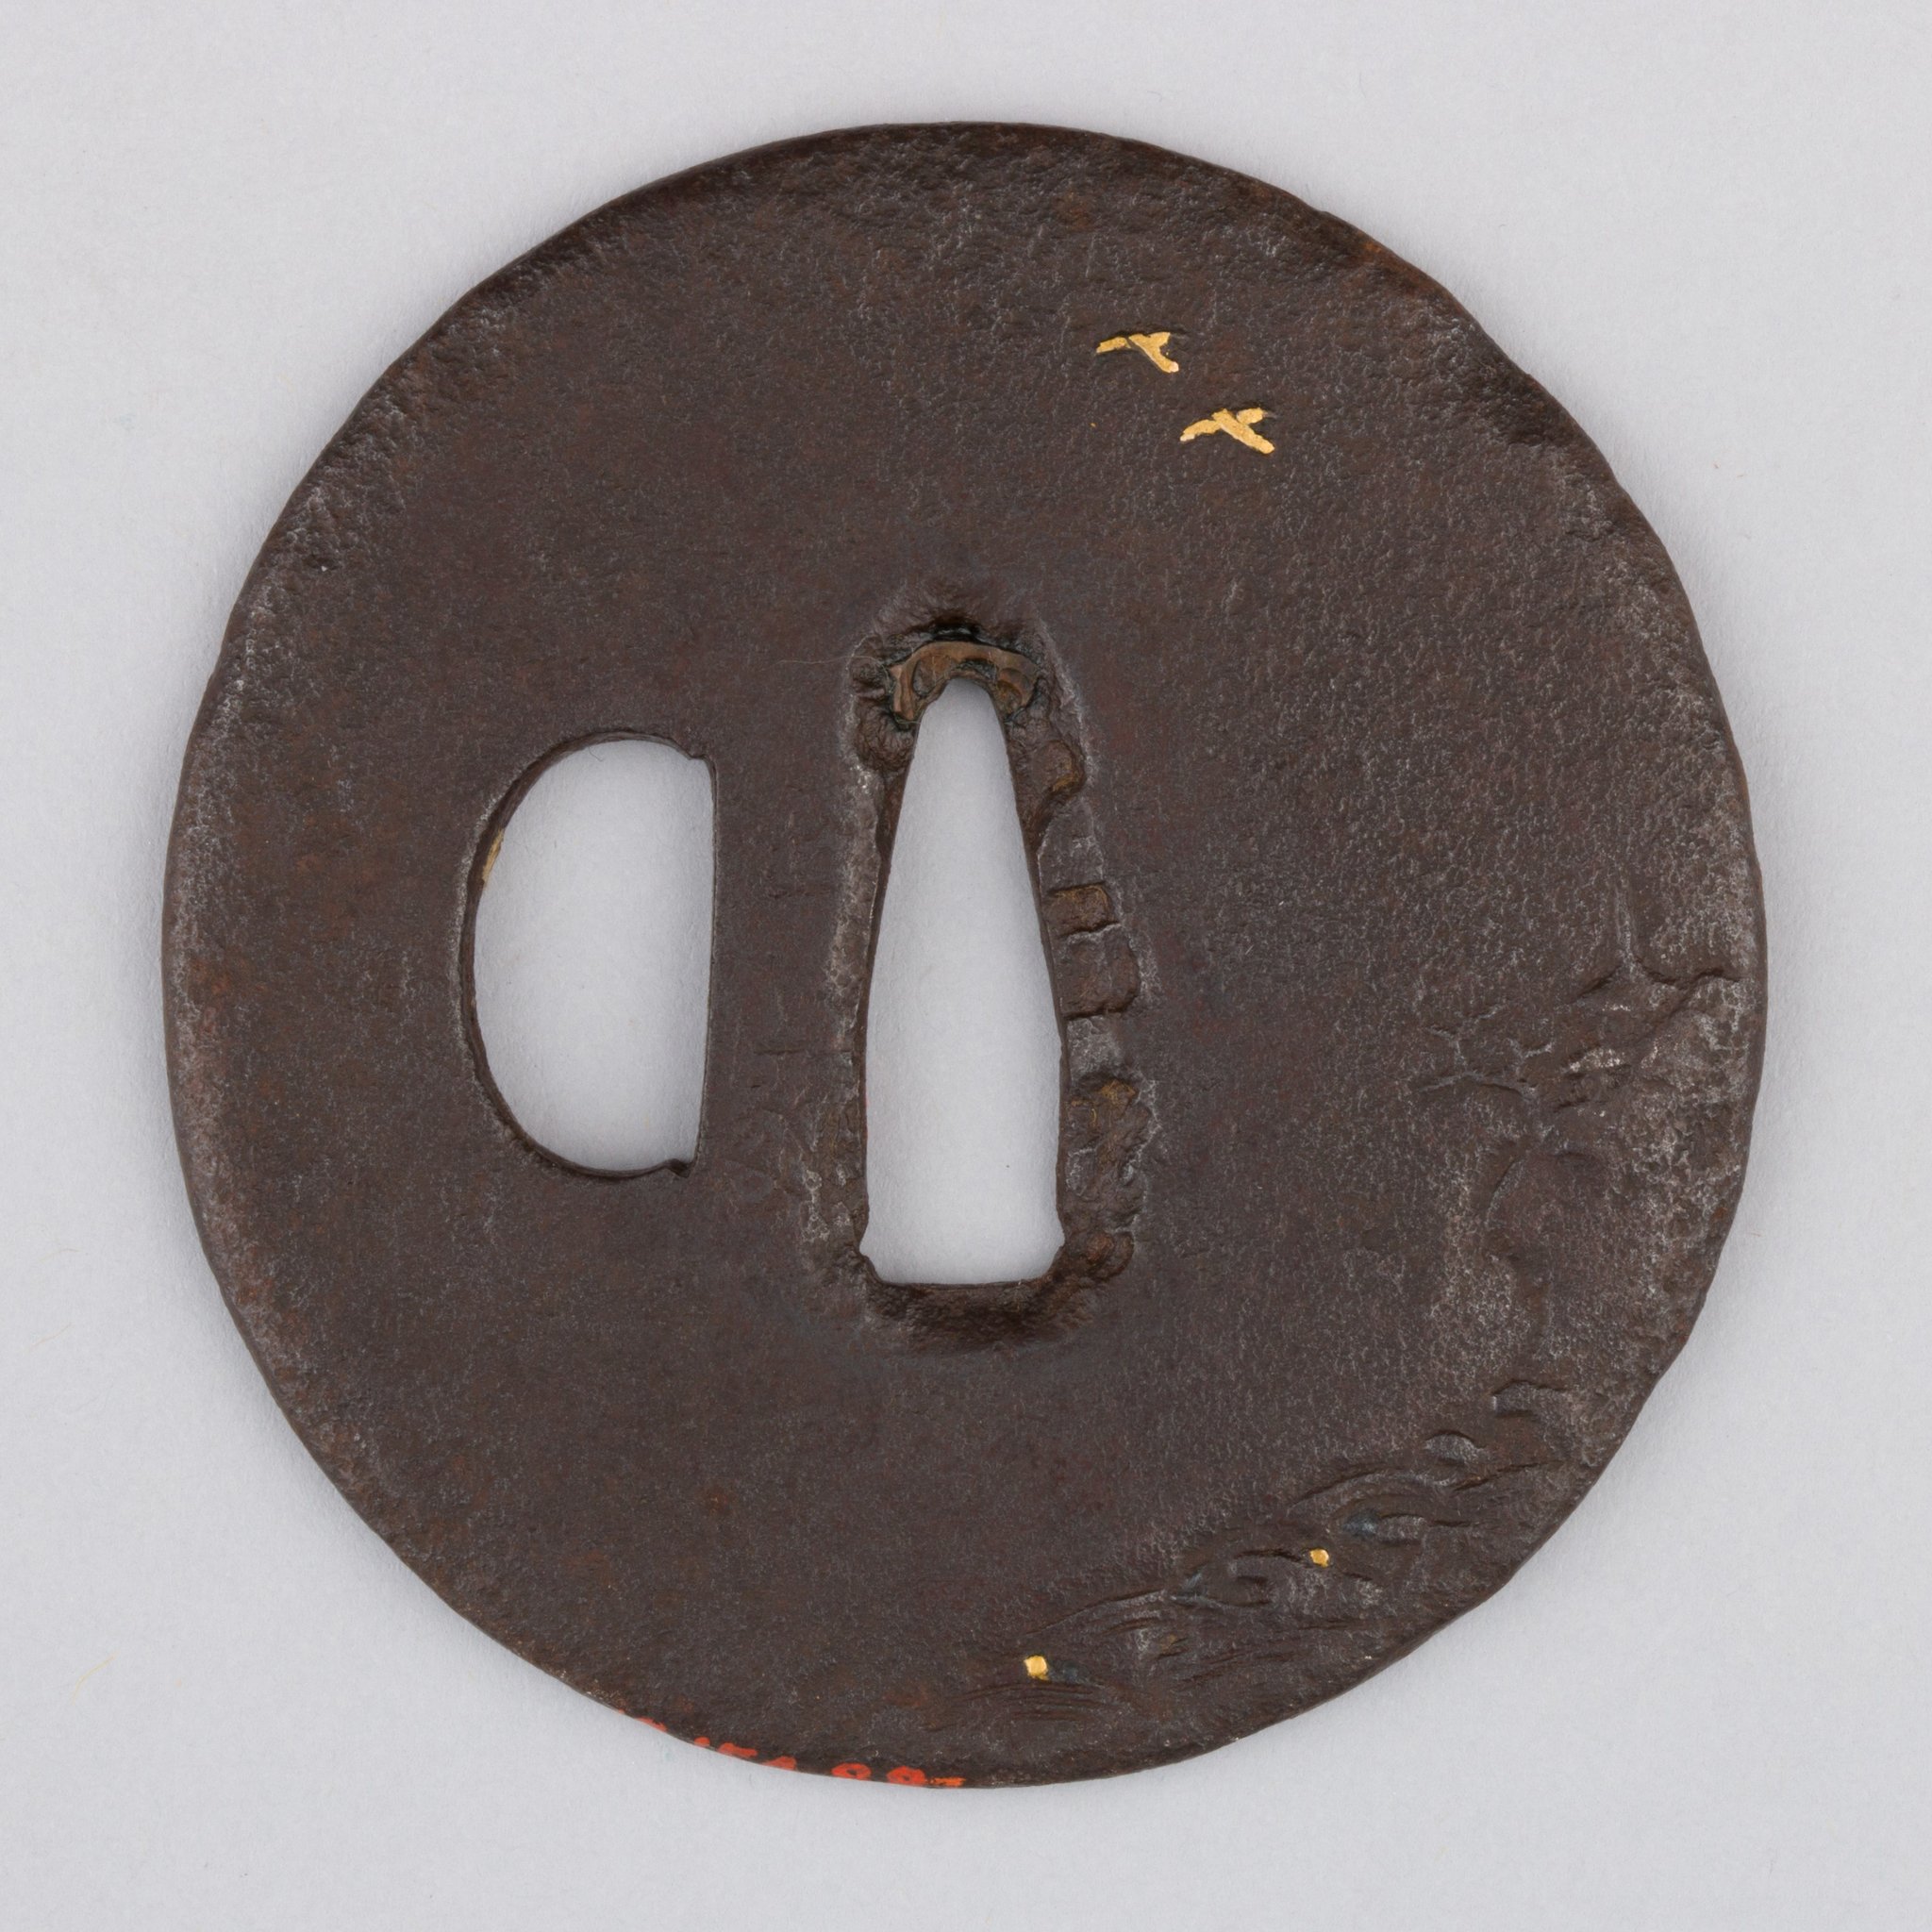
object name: sword guard tsuba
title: Sword Guard (Tsuba)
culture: japanese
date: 1615-1868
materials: copper, iron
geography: japan